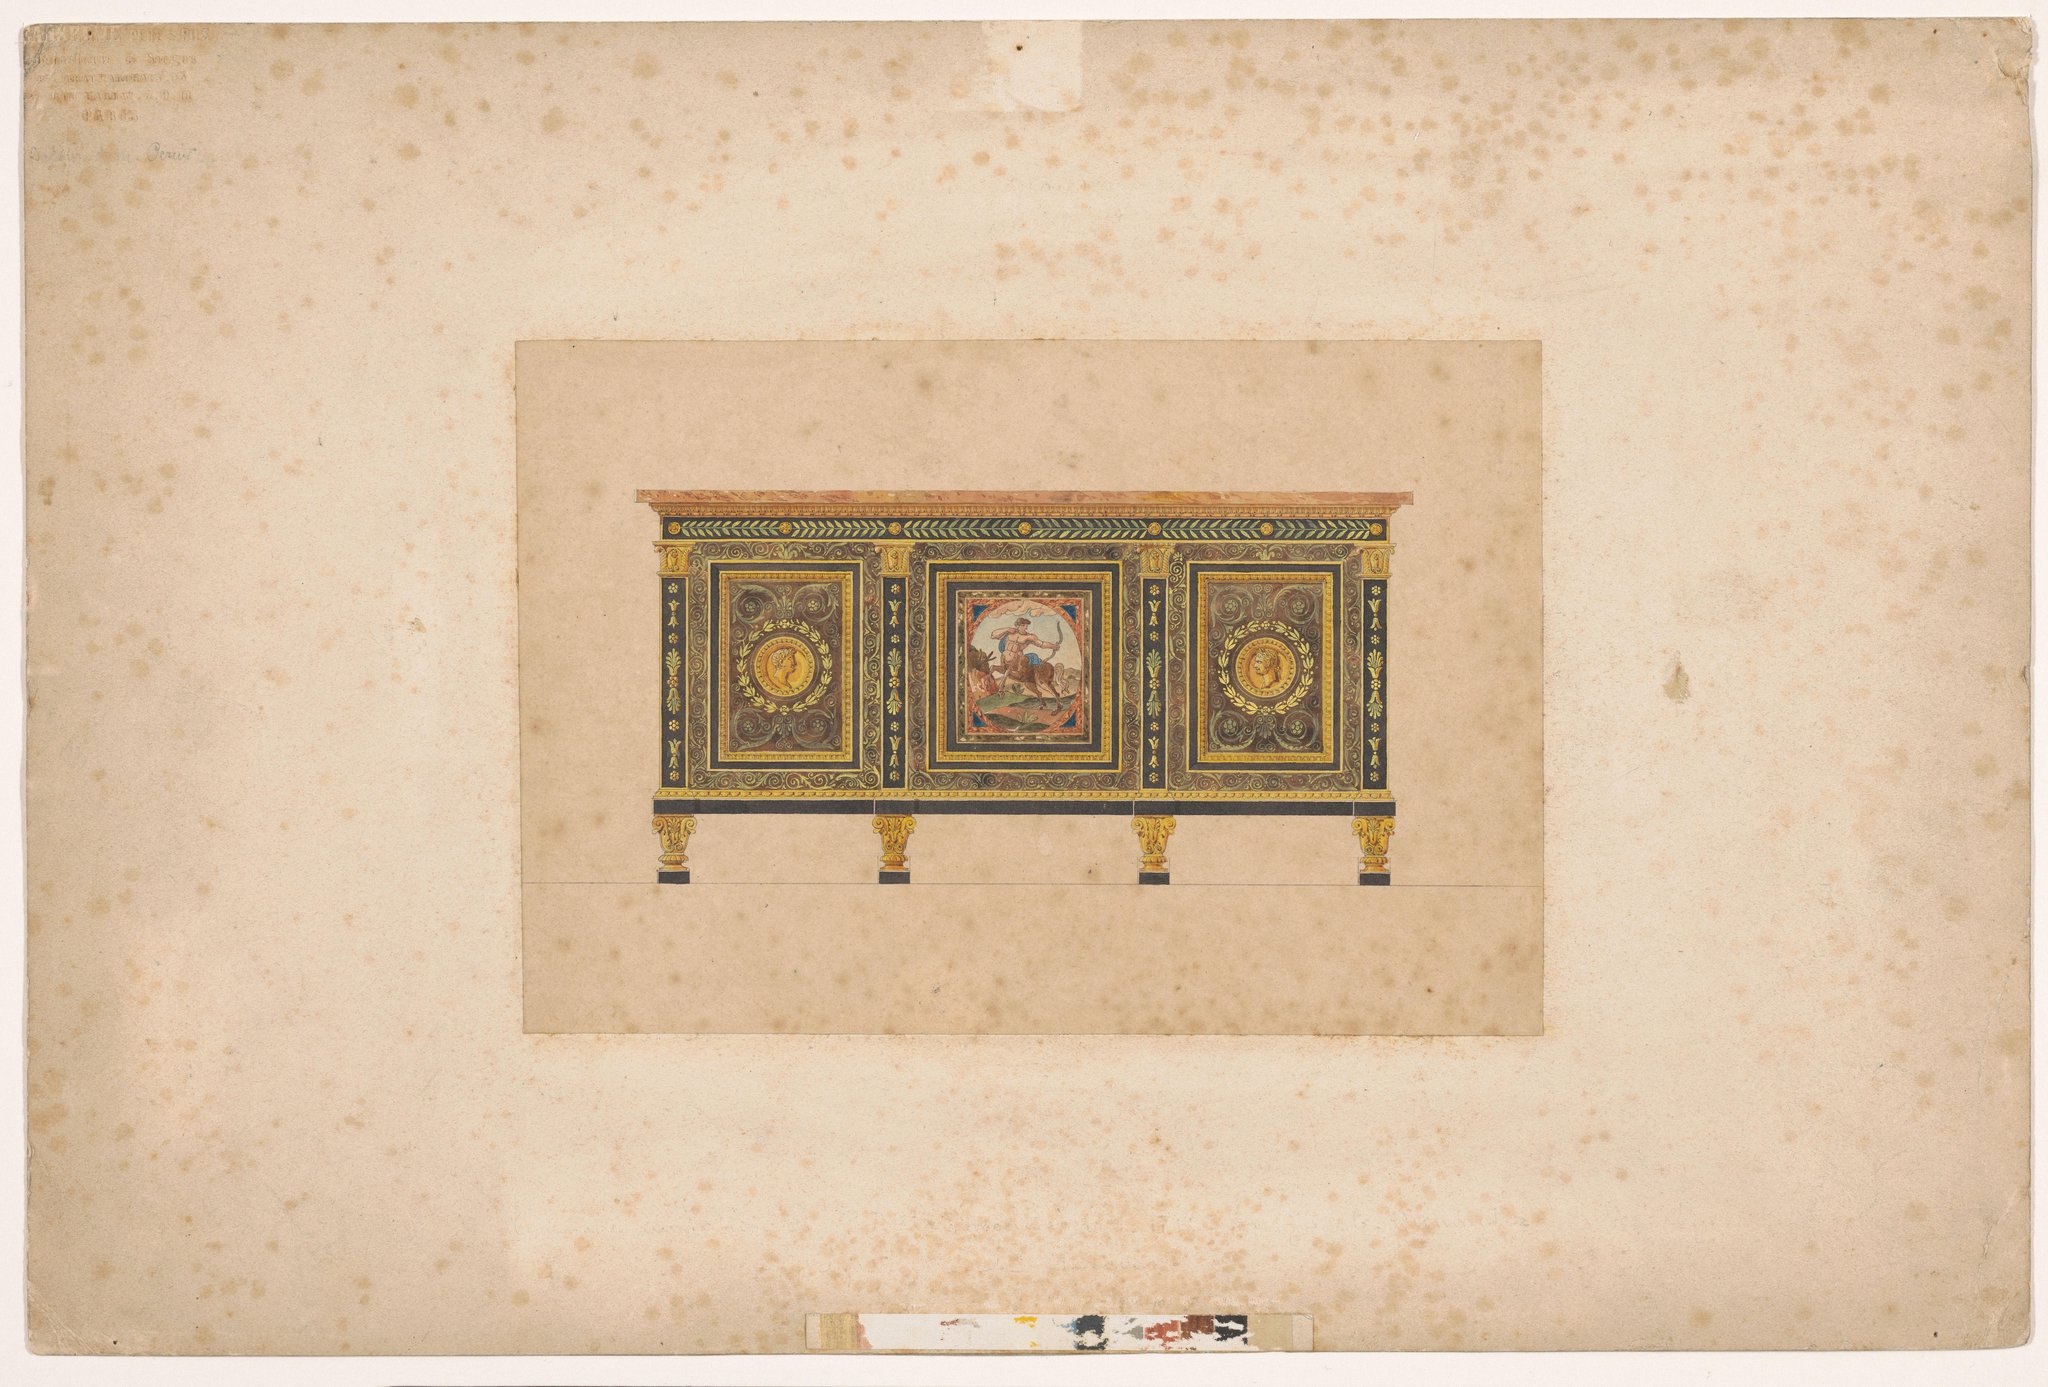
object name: drawing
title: Presentatietekening van een commode door de Parijse meubelmaker Jacob-Desmalter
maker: charles percier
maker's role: designer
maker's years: 1764-1838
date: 1810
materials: paper, watercolor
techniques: aquarelle, brush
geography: paris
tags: ornamental cupboard